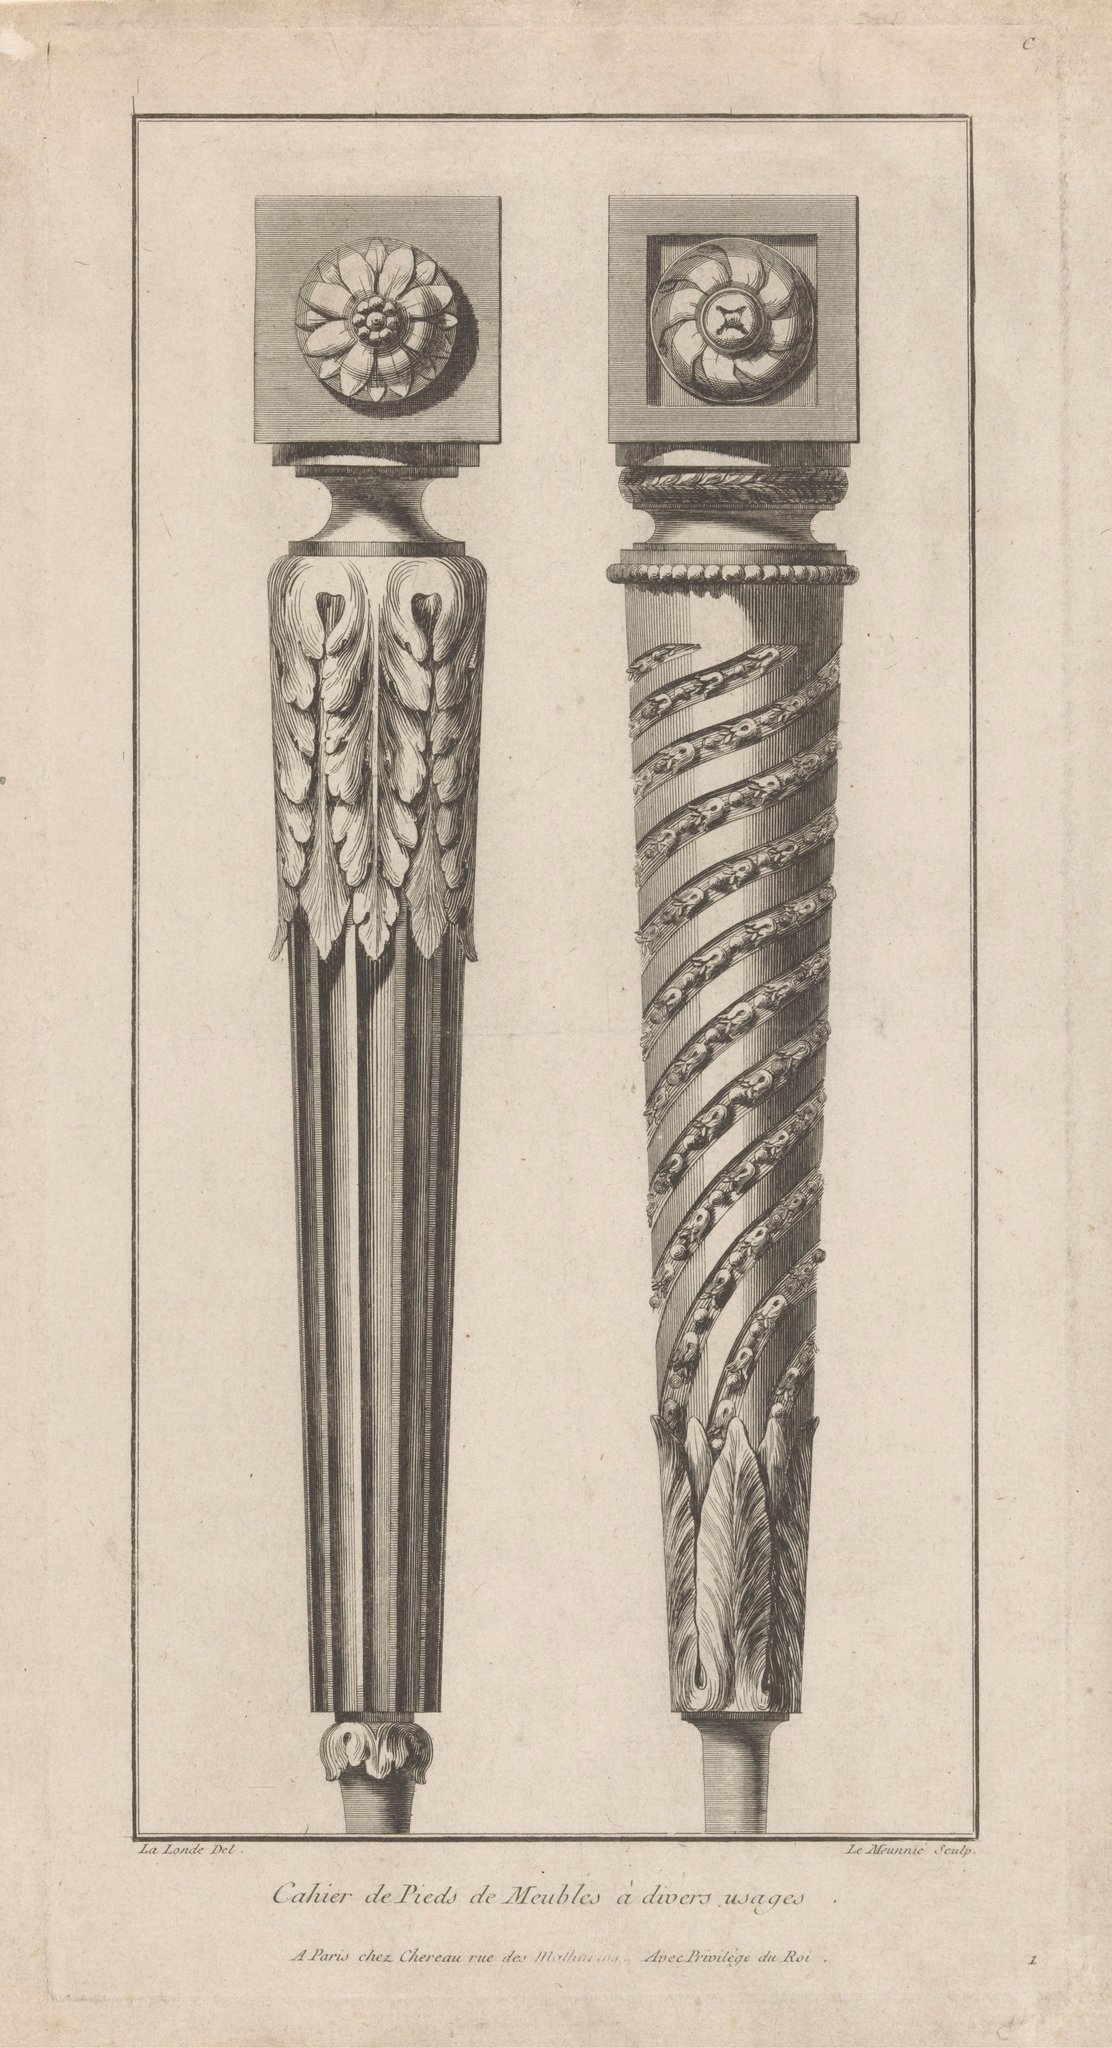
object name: ornament print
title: C Cahier de Pieds de Meubles à divers usages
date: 1784-1785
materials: paper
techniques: engraving, etching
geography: paris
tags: ornaments ~ art (+ framing decorations)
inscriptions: collector's mark: Lugt 2228, collector's mark: Lugt 2760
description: Twee geornamenteerde meubelpoten, links met bladmotieven, rechts met een spiraalvorm.